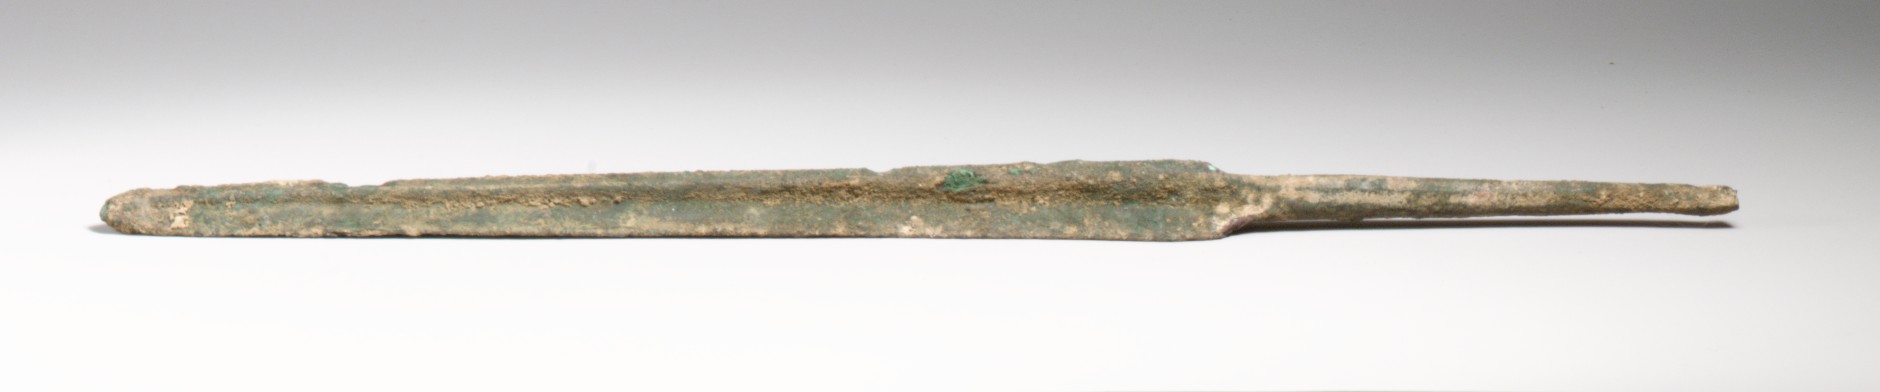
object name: dagger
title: Dagger blade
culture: cypriot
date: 3000-2000 BCE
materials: bronze